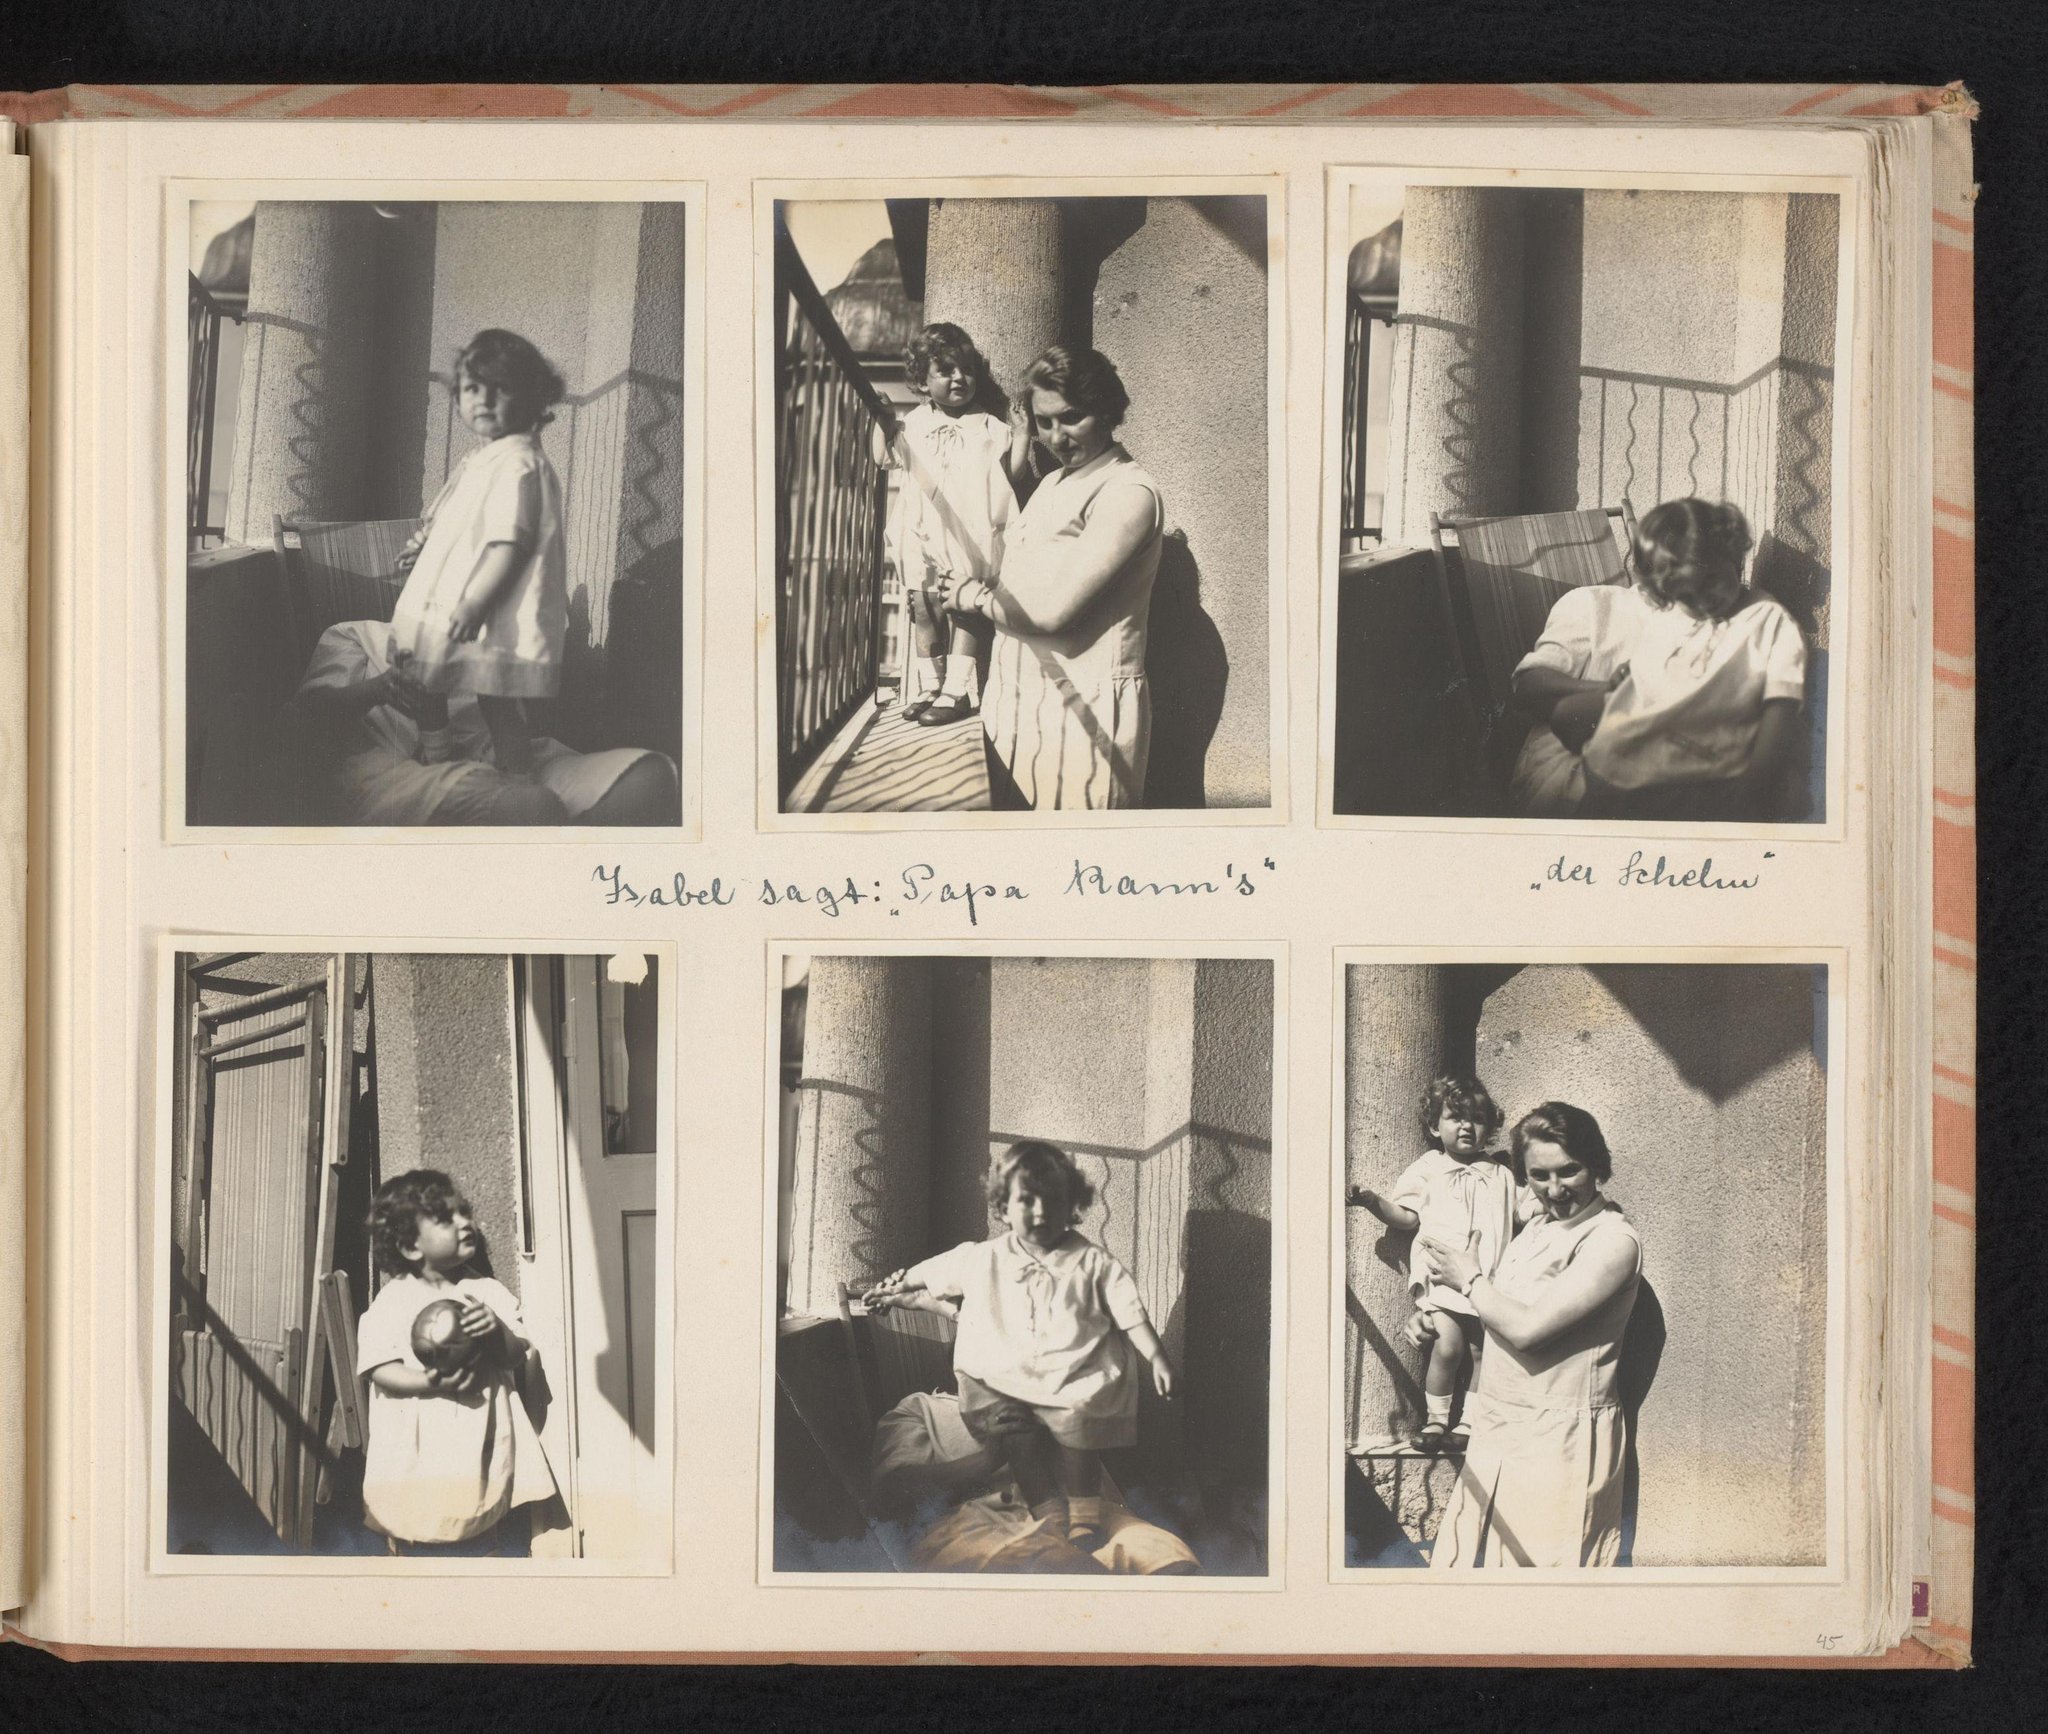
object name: photograph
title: Isabel Wachenheimer met onbekende vrouw in de zon op het balkon, april-mei 1930, München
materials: paper, photographic support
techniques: gelatin silver print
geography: munich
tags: leiden, isabel wachenheimer-elon, family life at home, infant, baby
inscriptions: inscription: ‘Isabel sagt:,,Papa kann's" ,,der ?"’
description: Albumblad met zes foto's. Foto's links en rechtsboven, links onder, midden onder, Isabel Wachenheimer; foto midden boven en rechts onder, Isabel Wachenheimer (links) en onbekende vrouw (rechts). Onderdeel van het fotoalbum met foto's van Isabel Wachenheimer als kind (1928-1931).